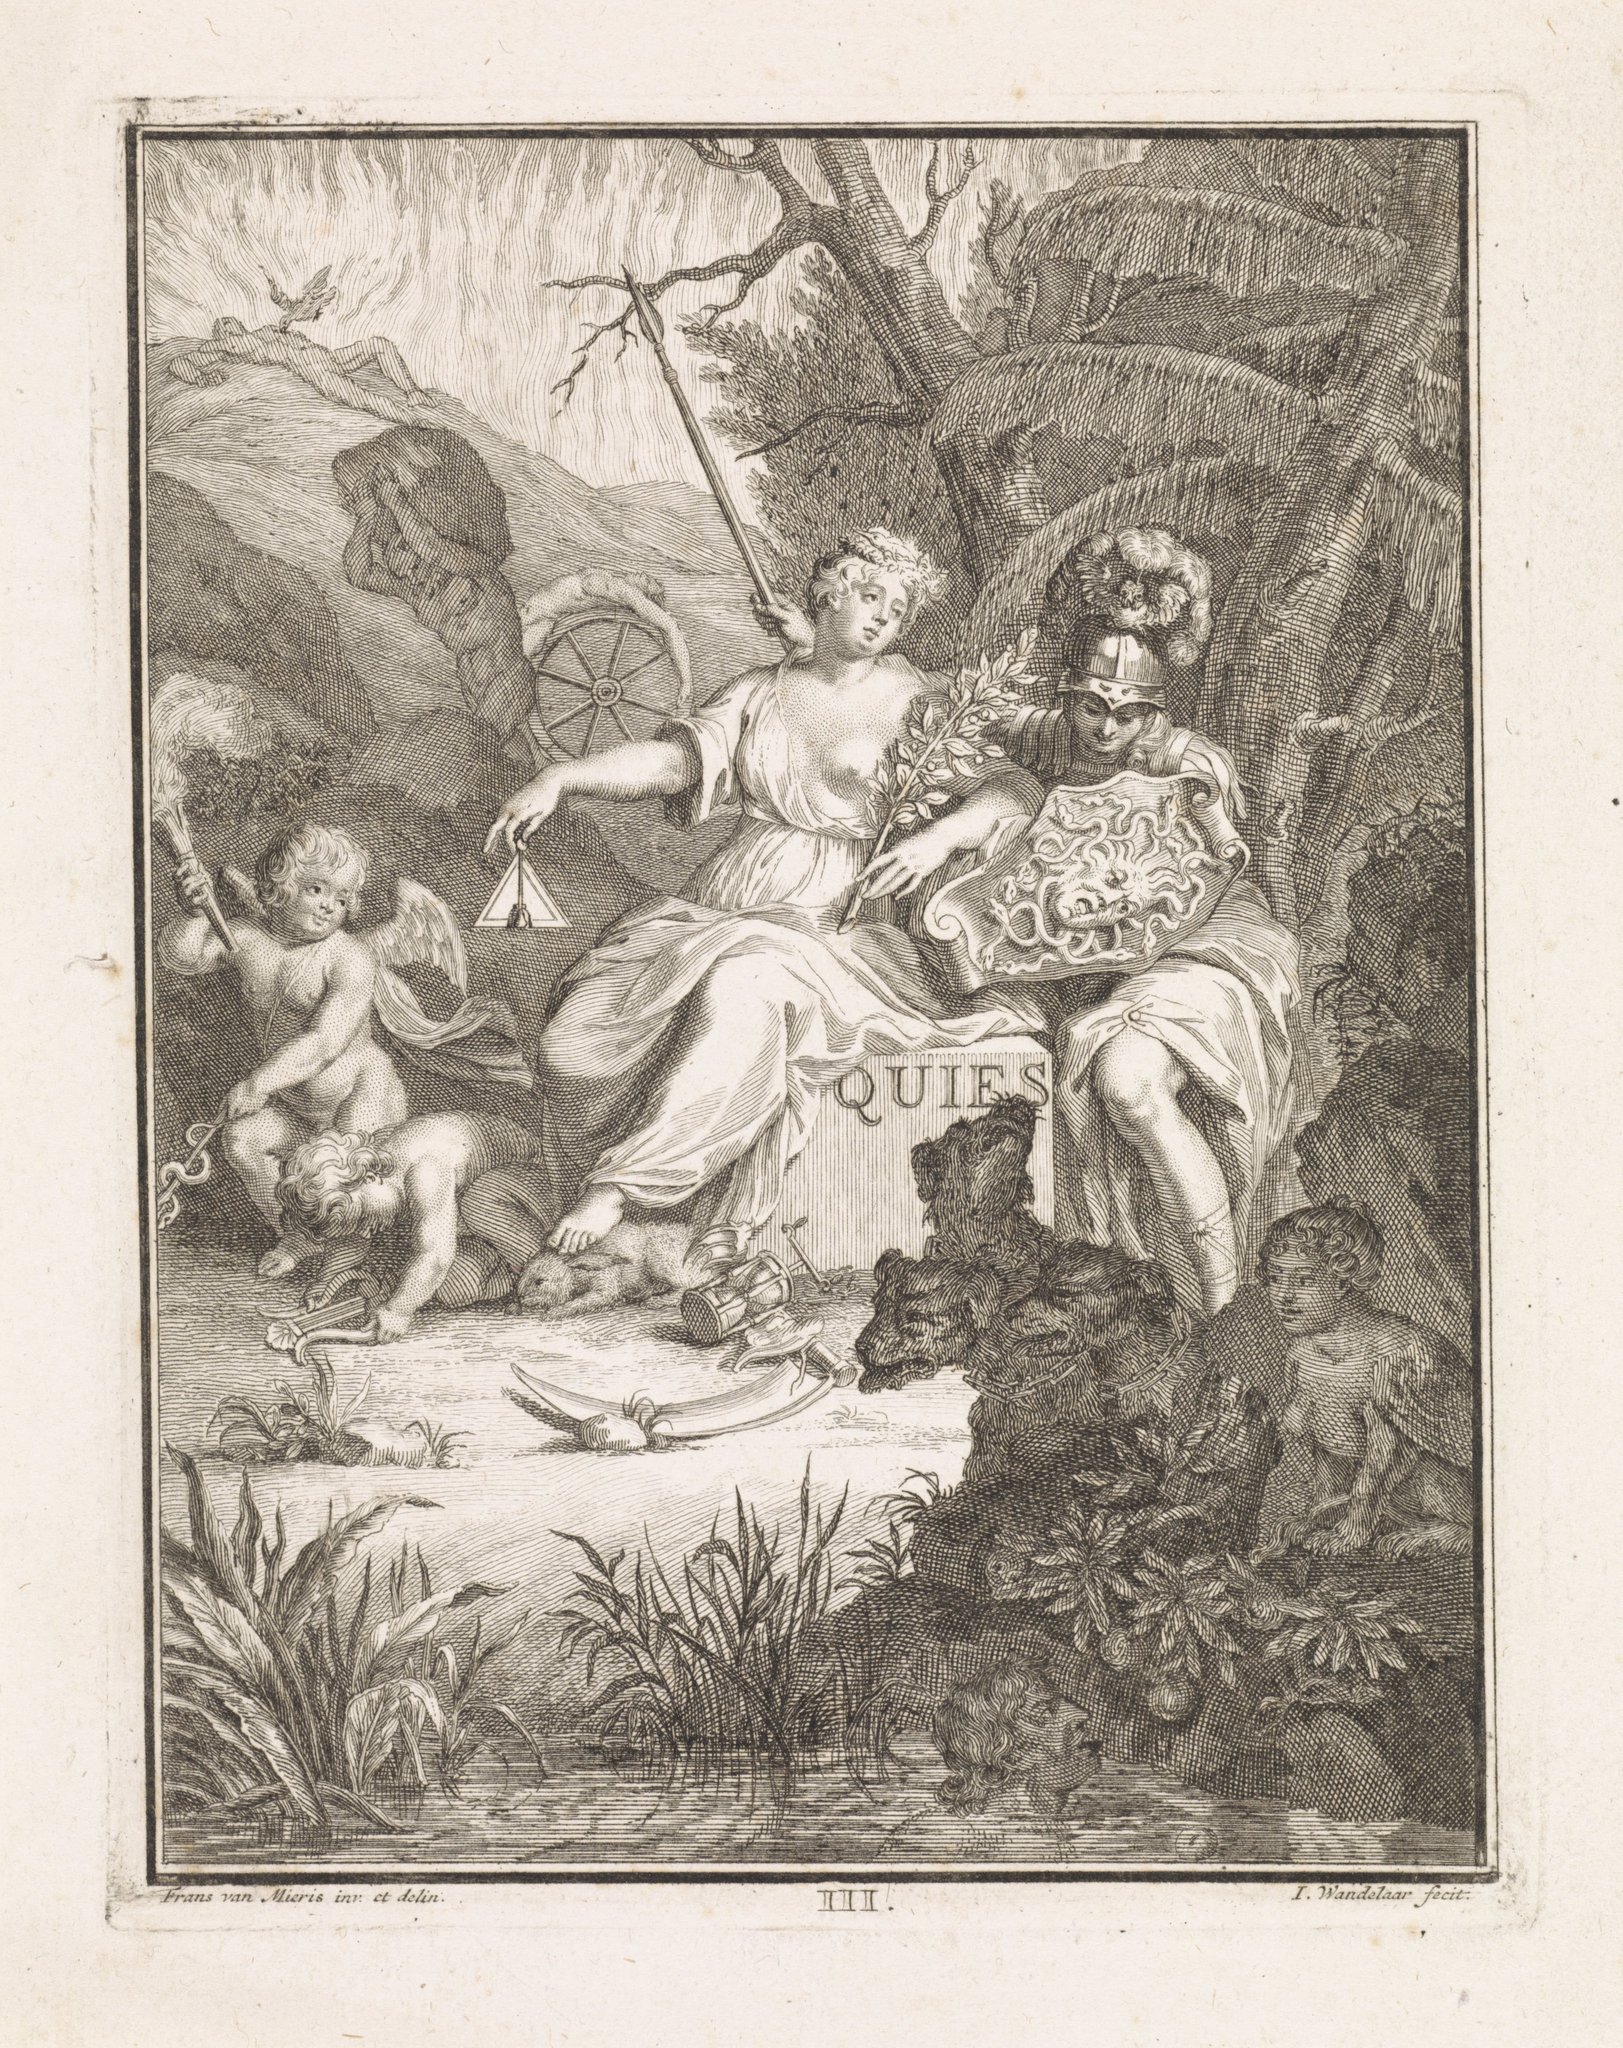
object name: print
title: Allegorische vrouwfiguur en Minerva in een landschap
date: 1725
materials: paper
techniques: engraving, etching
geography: northern netherlands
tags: (story of) minerva (pallas, athena), representations of hell (with the damned and devils), usually with burning fires, accessories ~ music: metronome, music-stand, tuning-fork, etc., other allegories of time, e.g. 'tempo' (ripa), harpy (fabulous bird); 'arpie' (ripa)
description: Landschap met een vrouwfiguur, in haar handen een metronoom en een olijftak, haar voet op een konijn. Voor haar de attributen van Vader Tijd. Ze is vergezeld door Minerva en twee putti, met een lier en caduceus in de handen. Op de voorgrond een rivier met een man in het water. Hij steekt zijn tong uit naar een harpij op de oever. Op de achtergrond figuren die gemarteld worden in de hel. Midden onder genummerd: III.